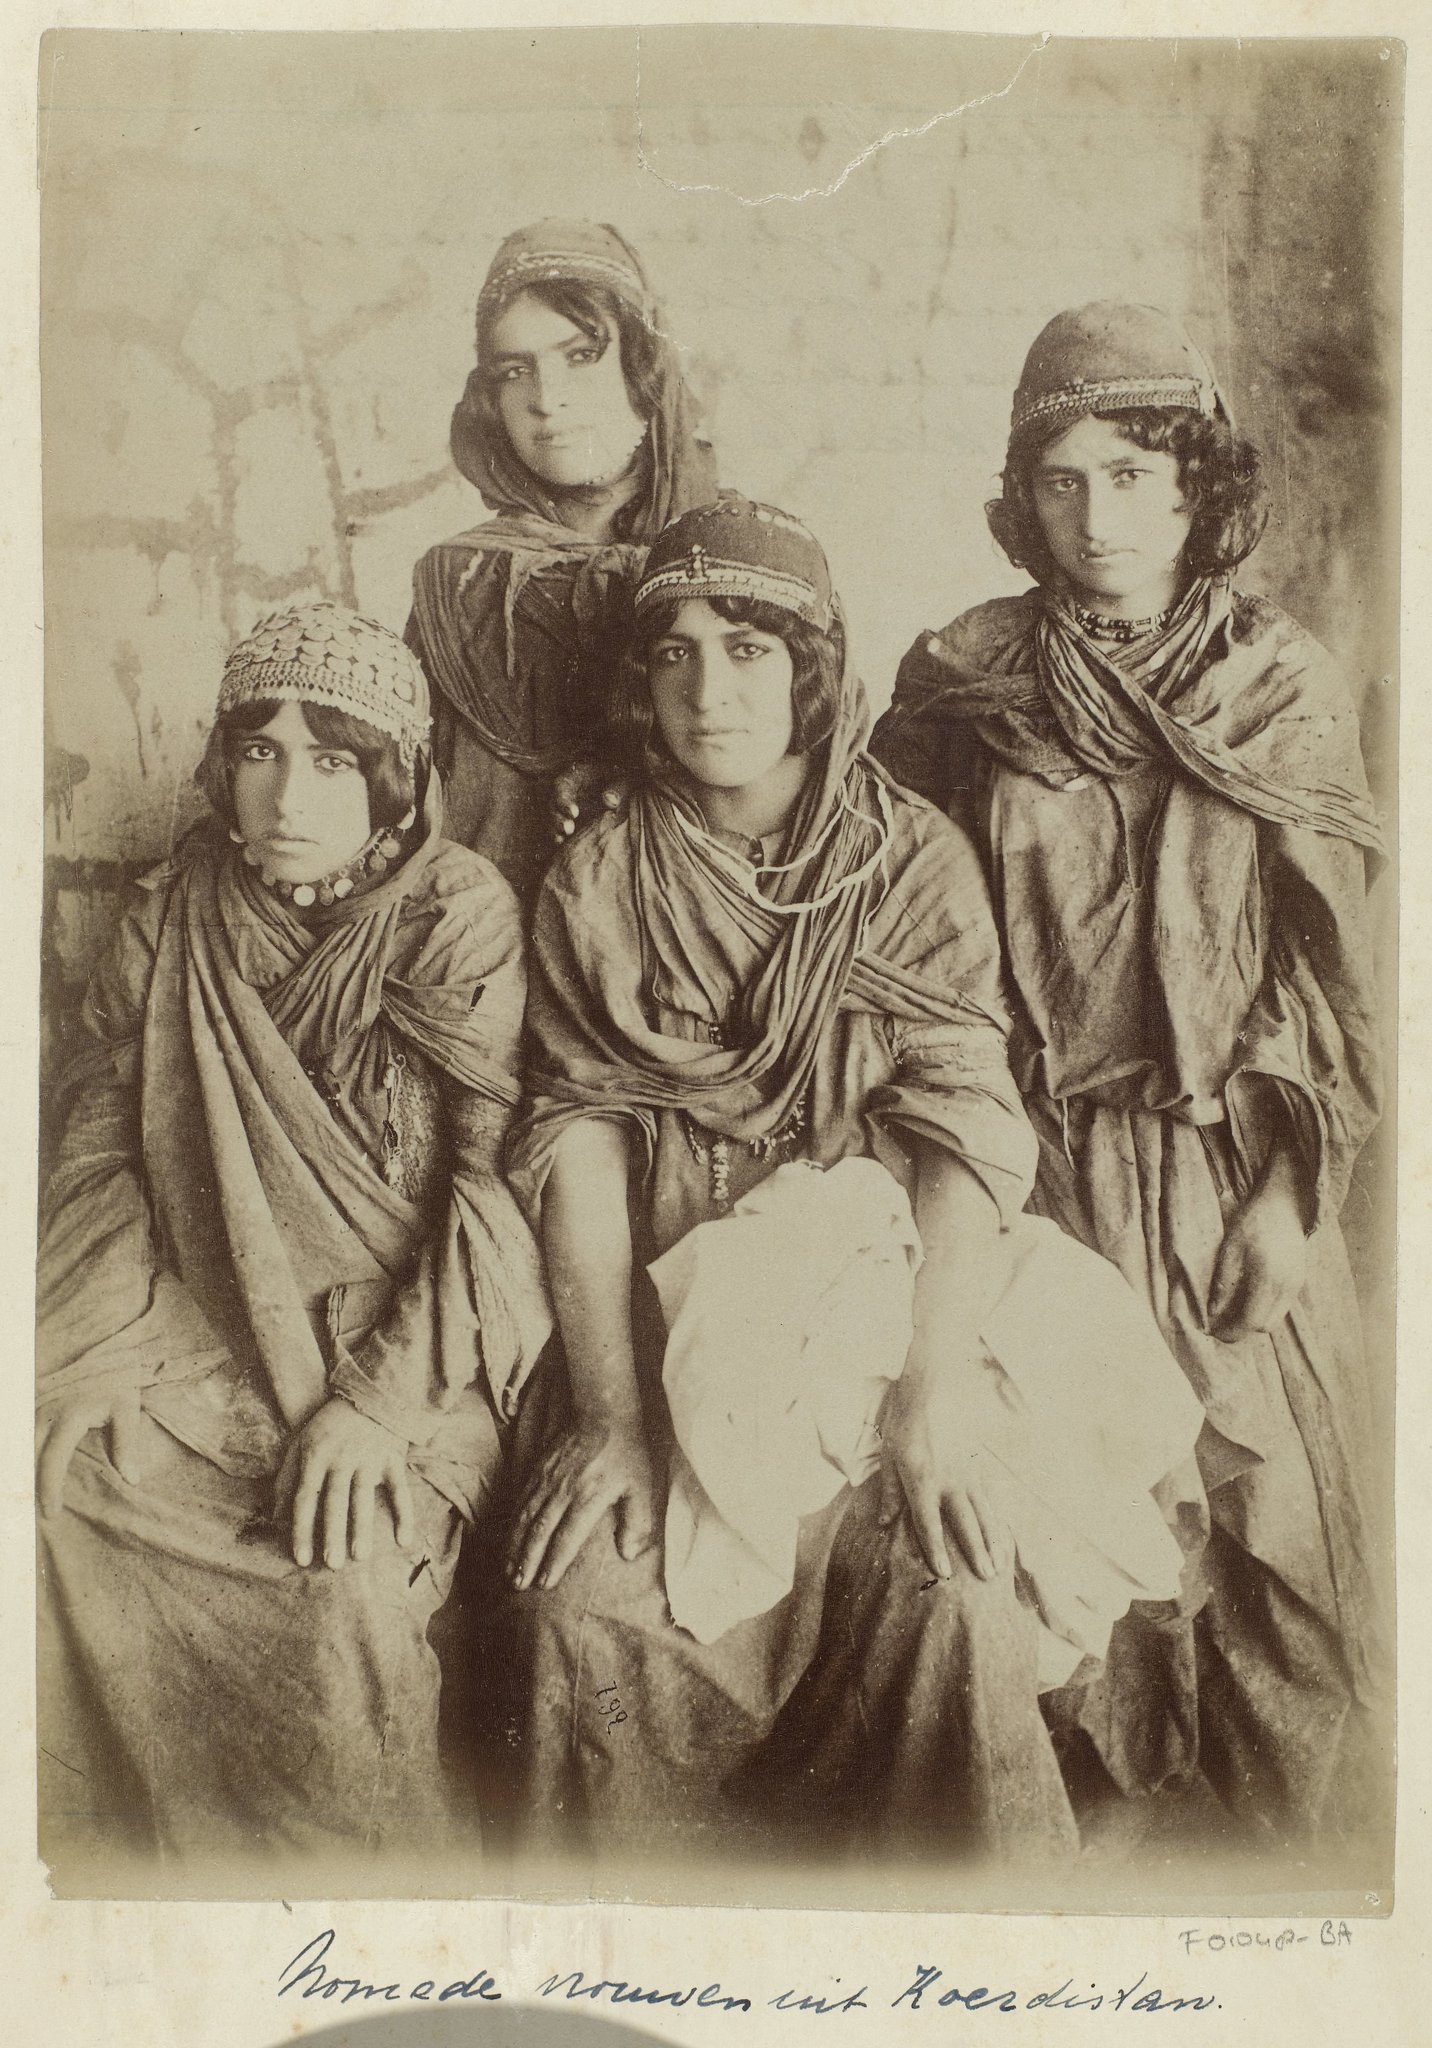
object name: photograph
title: Nomade vrouwen uit Koerdistan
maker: antoine sevruguin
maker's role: fotograaf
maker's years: 1840-1933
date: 1880-1895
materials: paper, photographic support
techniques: albumen print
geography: kurdistan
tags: adolescent, young woman, maiden, folk costume, regional costume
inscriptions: negative number: ‘799’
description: Onderdeel van Reisalbum van H. Dunlop met foto's van bezienswaardigheden in Perzië, Schotland, Duitsland, Rusland, China en Canada.